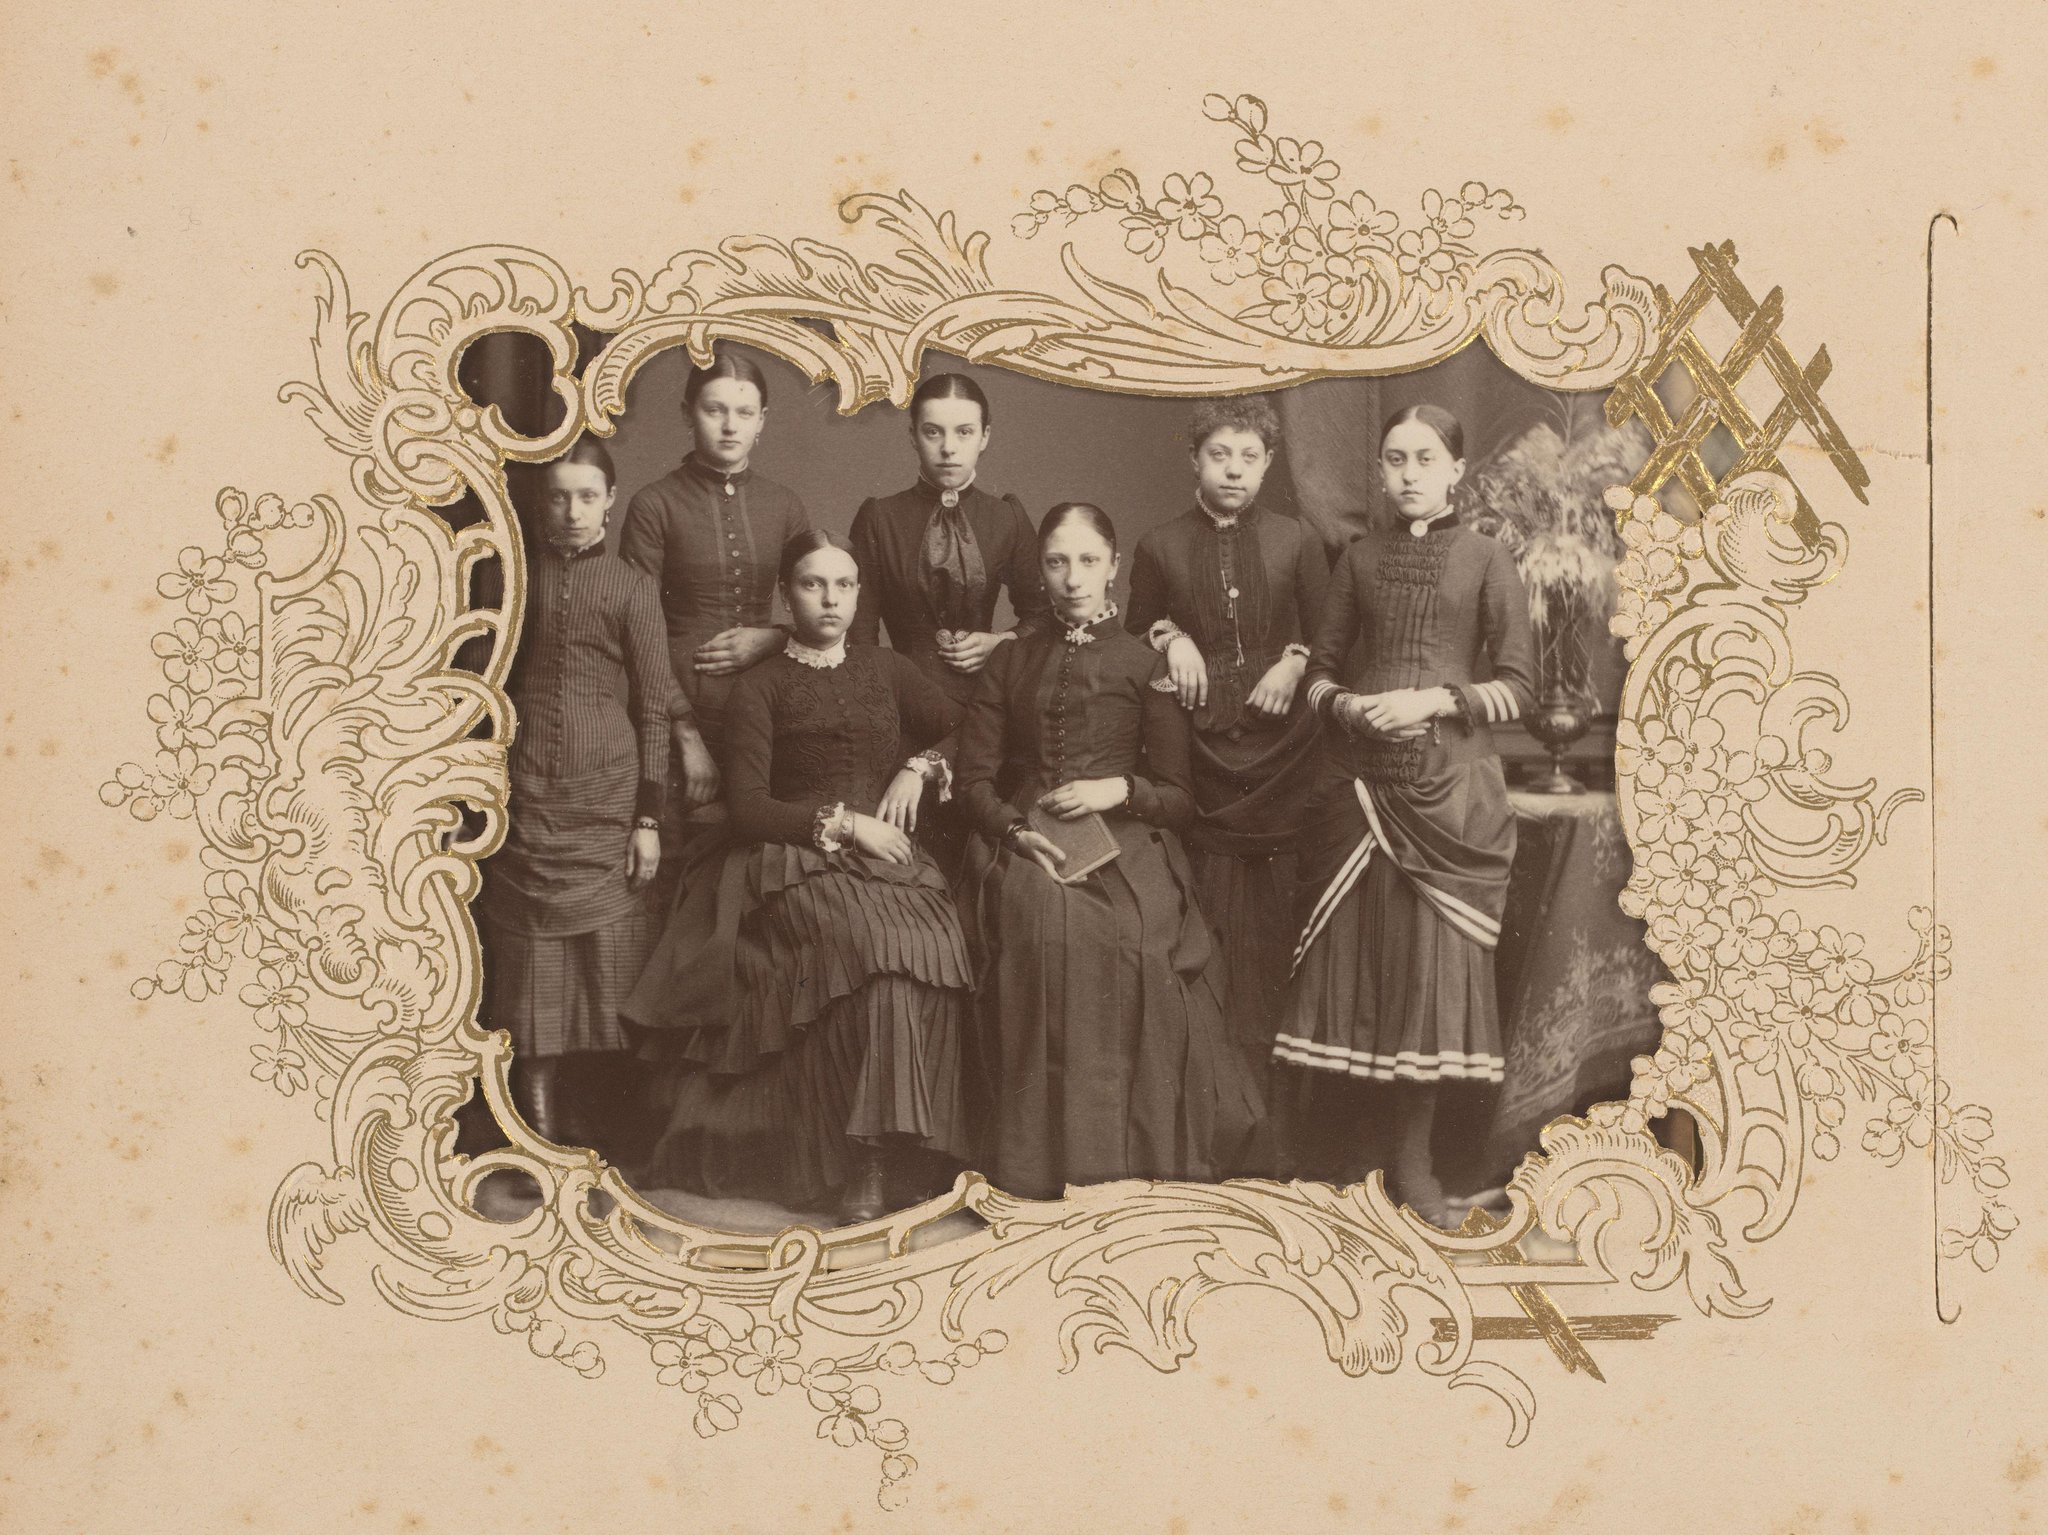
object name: photograph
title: Groepsportret van zeven jonge vrouwen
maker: Anonymous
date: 1860-1890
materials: cardboard, photographic support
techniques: albumen print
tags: anonymous historical persons portrayed in a group, in a group-portrait - bb - woman